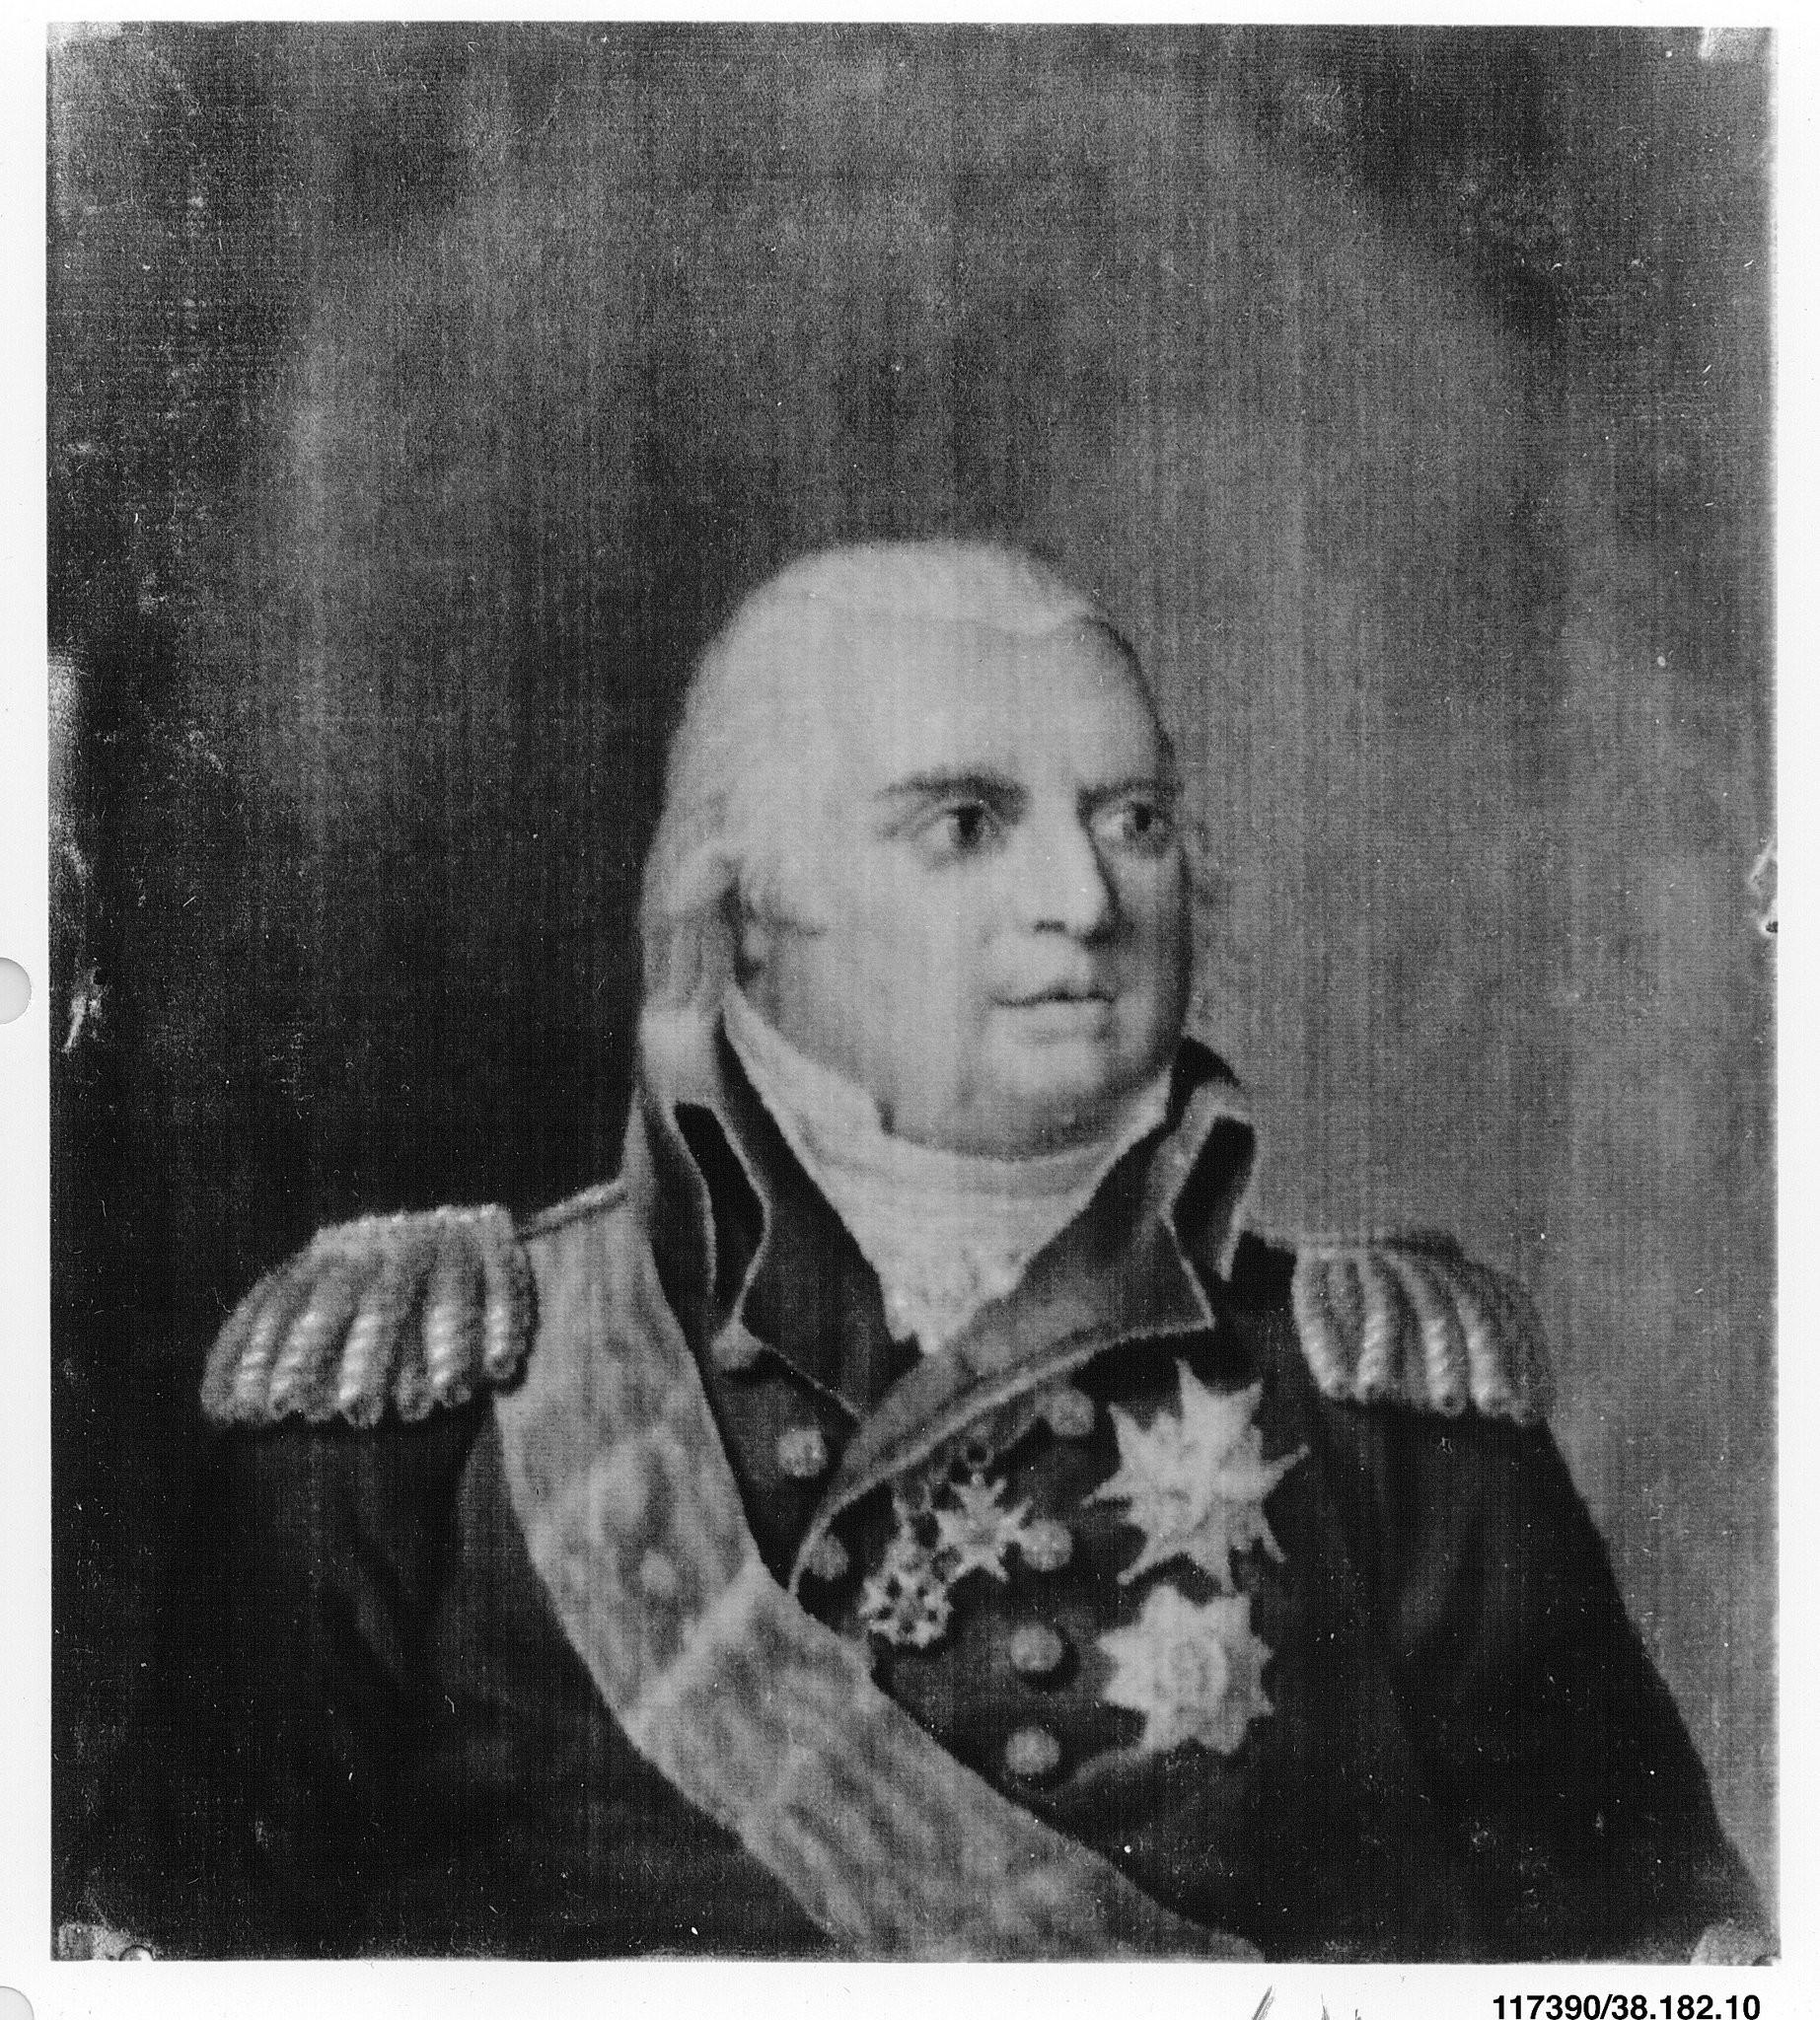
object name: panel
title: Portrait of Louis XVIII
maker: gaspard grégoire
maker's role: designer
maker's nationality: french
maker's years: 1751-1846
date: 1801-1833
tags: kings,portraits